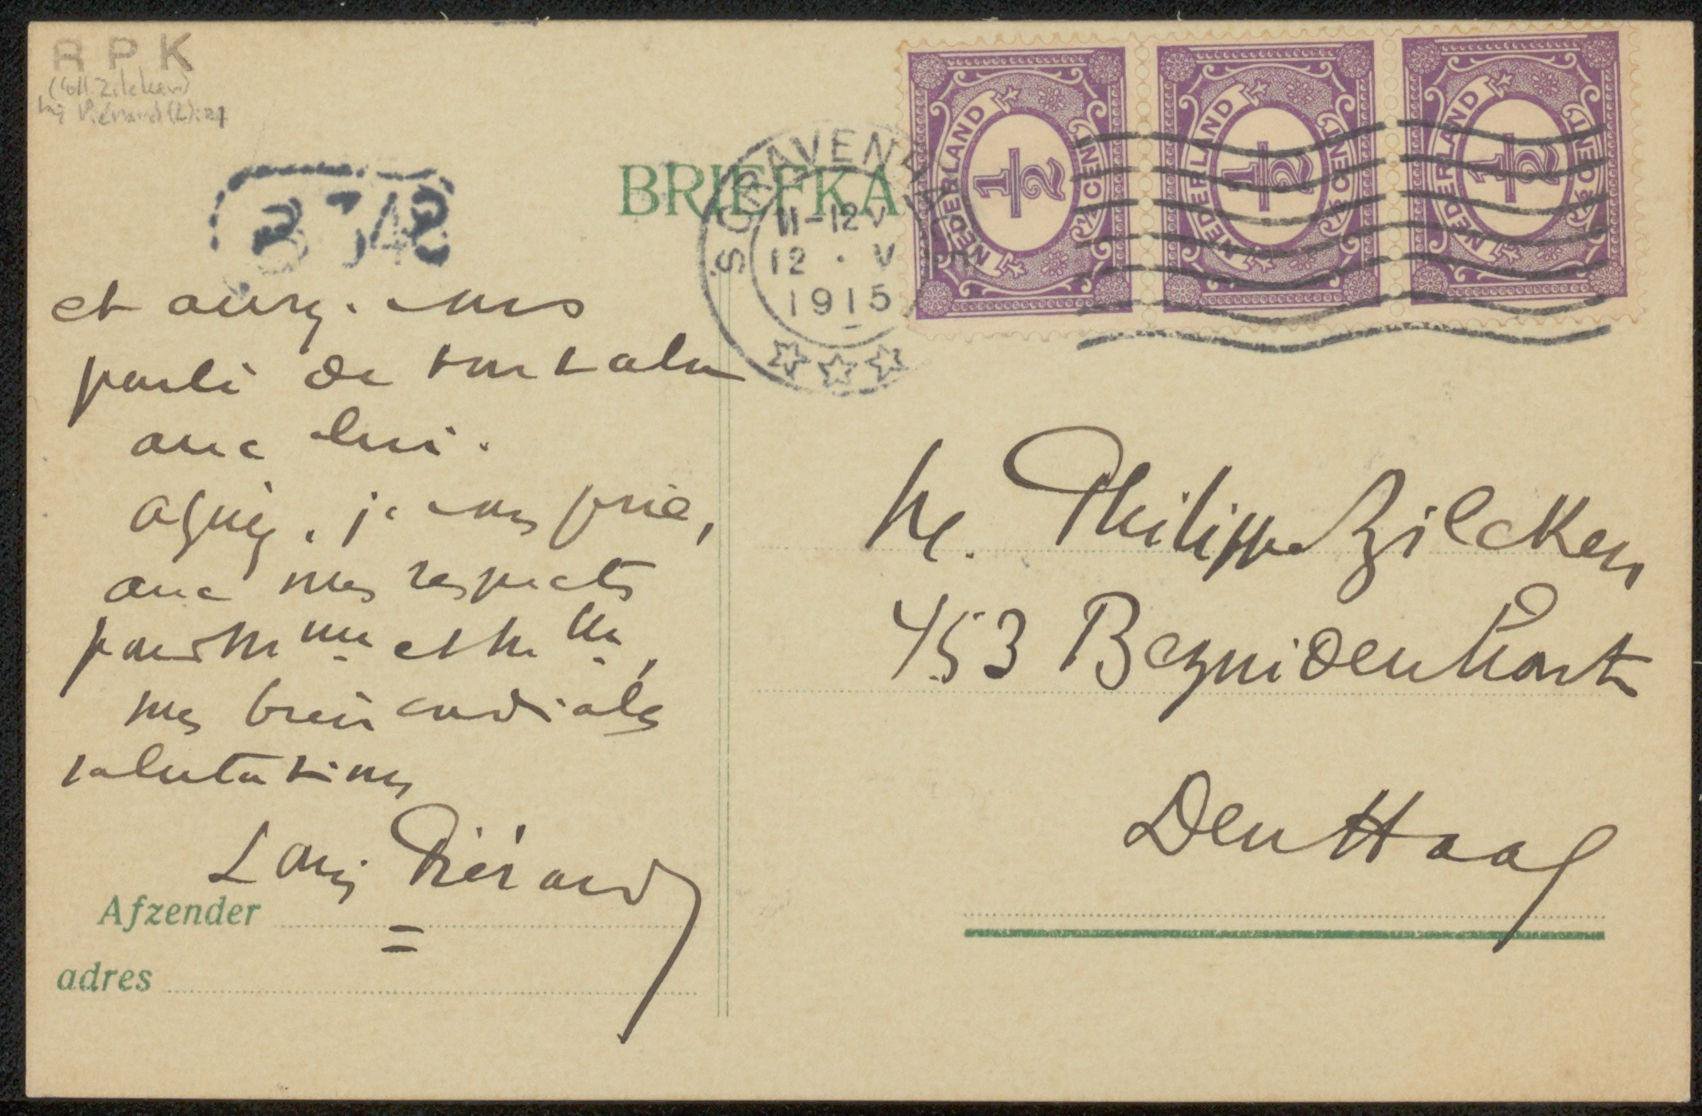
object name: postcard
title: Briefkaart aan Philip Zilcken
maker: louis piérard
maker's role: letterkundige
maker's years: 1886-1951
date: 1915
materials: cardboard, ink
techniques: pen, writing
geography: the hague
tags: draughtsman, edmond de goncourt, etienne dinet, marseille, gabriel mourey, the hague, philip zilcken, printed matter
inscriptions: collector's mark: ‘RPK’